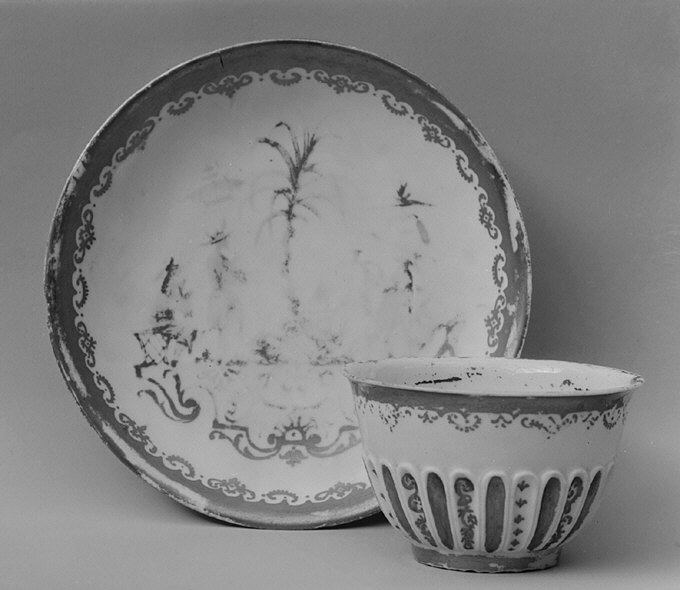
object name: cup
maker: meissen manufactory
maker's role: manufactory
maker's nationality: german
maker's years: 1710-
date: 1720-1725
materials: hard paste porcelain